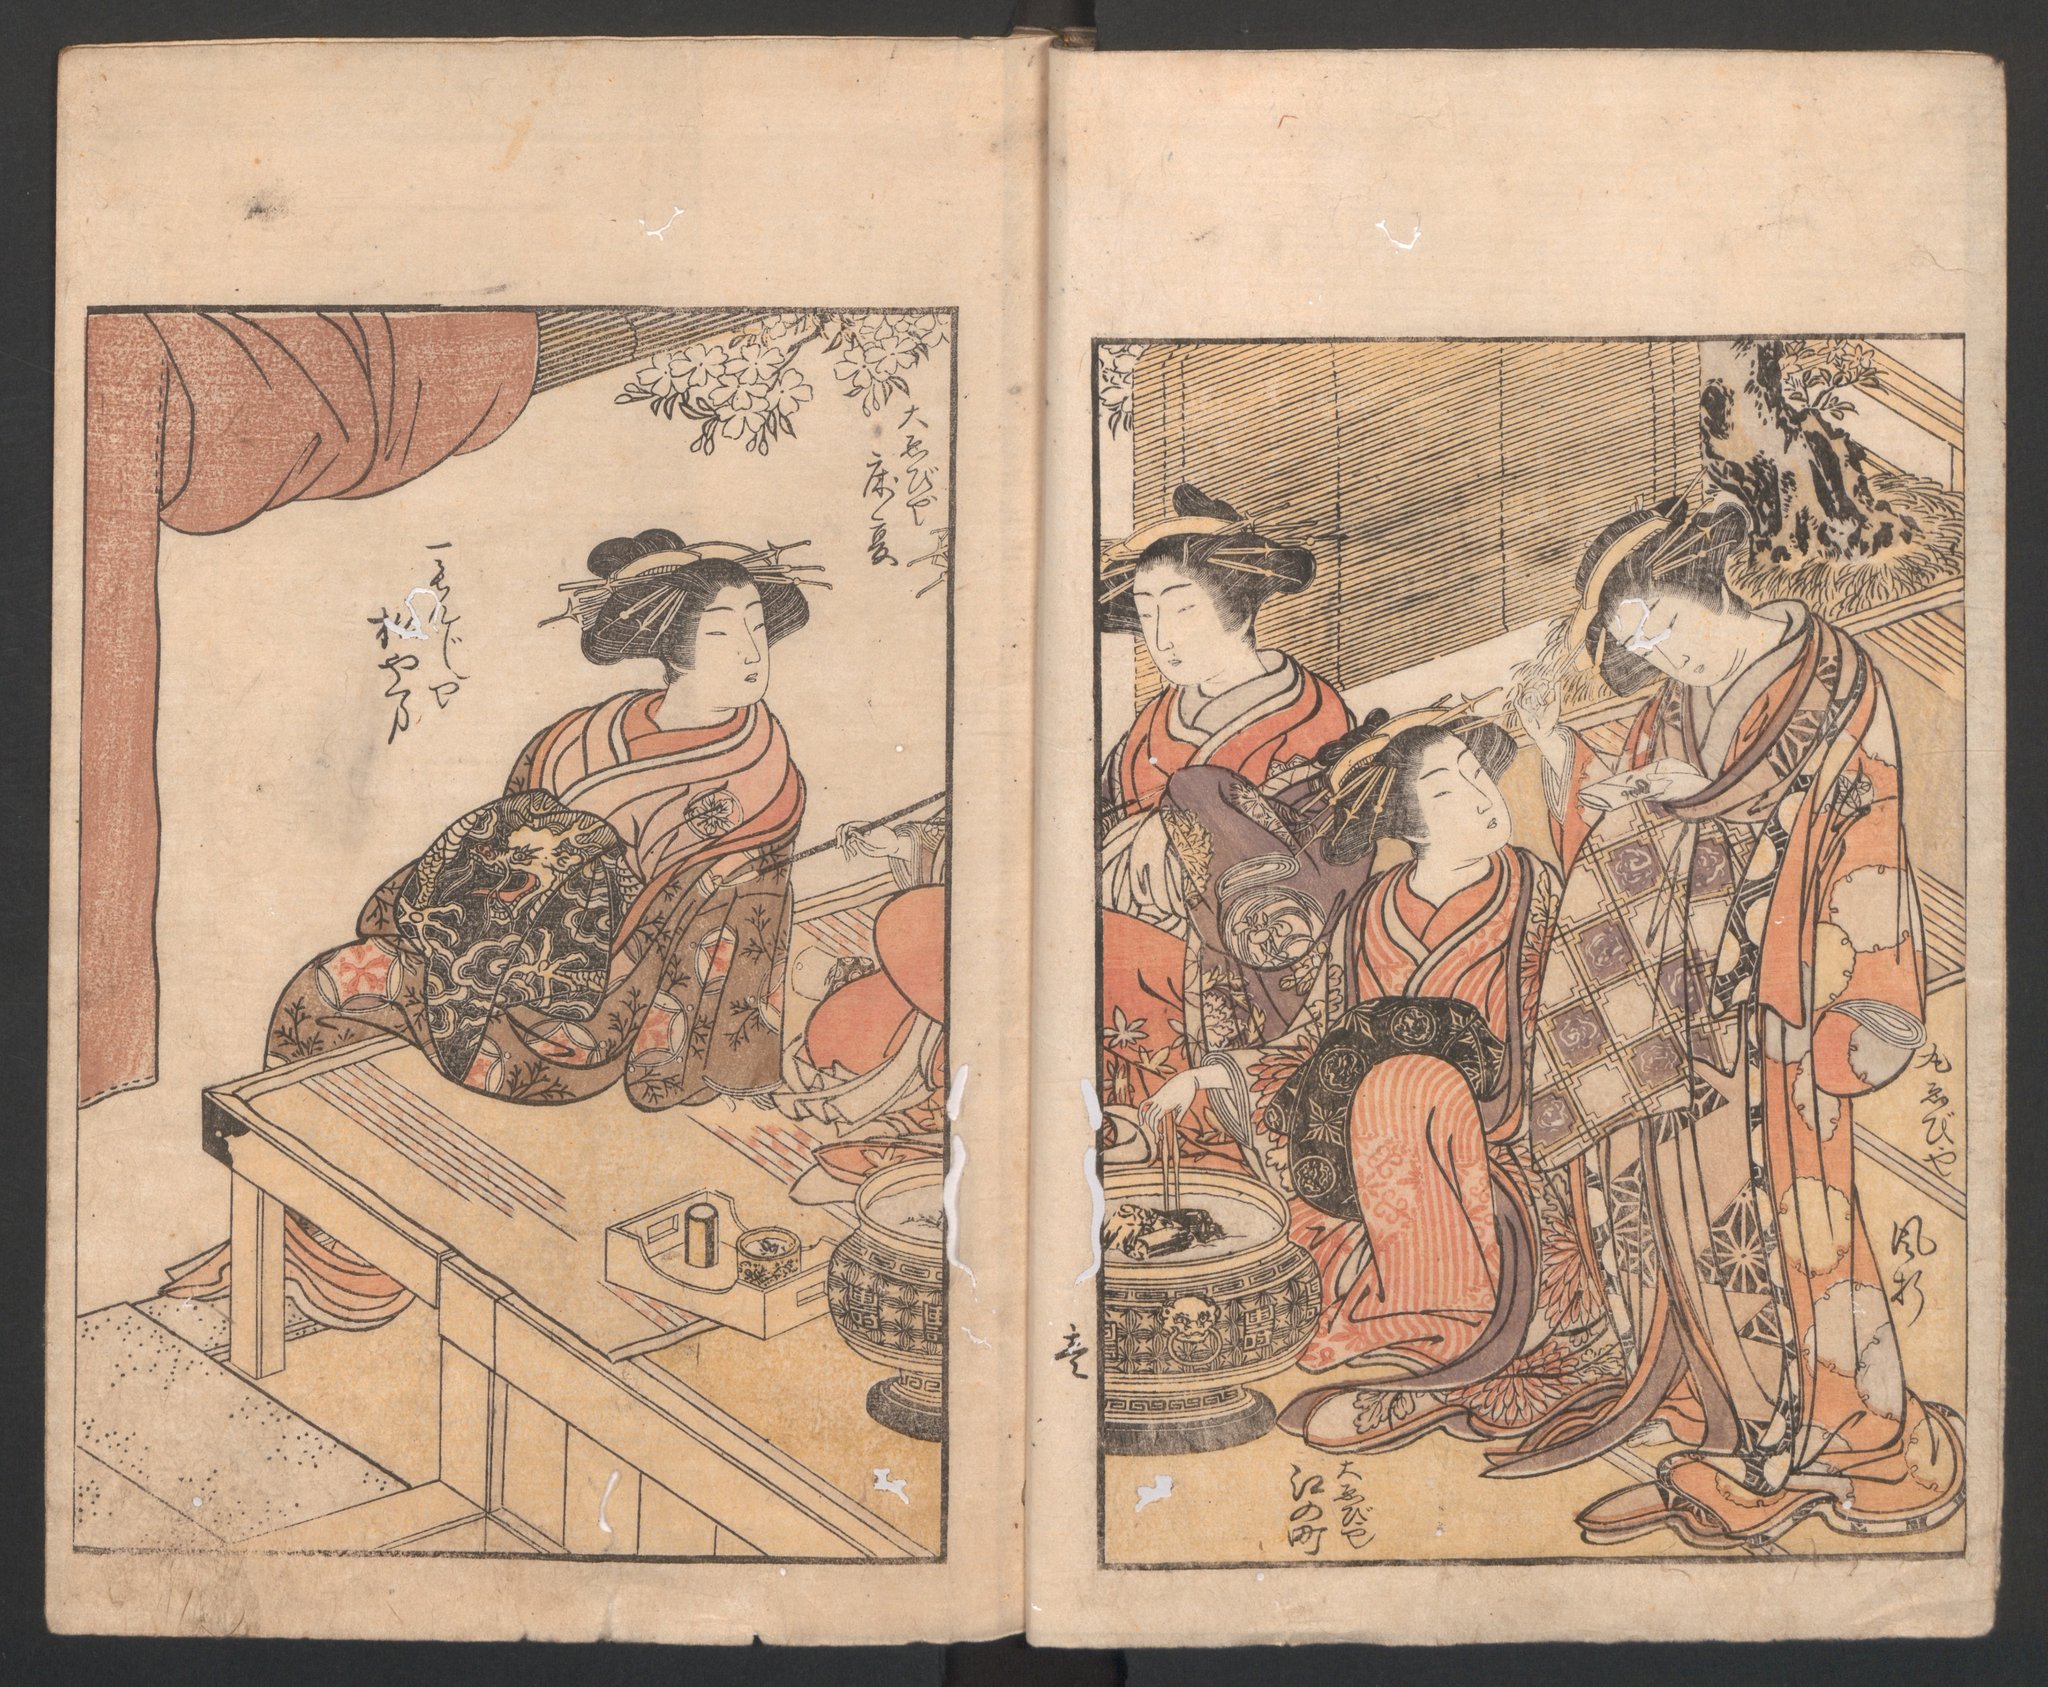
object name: illustrated book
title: Mirror of the Beauties of the Green-houses (Seirō bijin awase sugata kagami) 青楼美人合姿鏡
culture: japanese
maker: katsukawa shunshō 勝川春章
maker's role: artist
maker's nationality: japanese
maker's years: 1726-1792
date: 1776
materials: ink, paper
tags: women